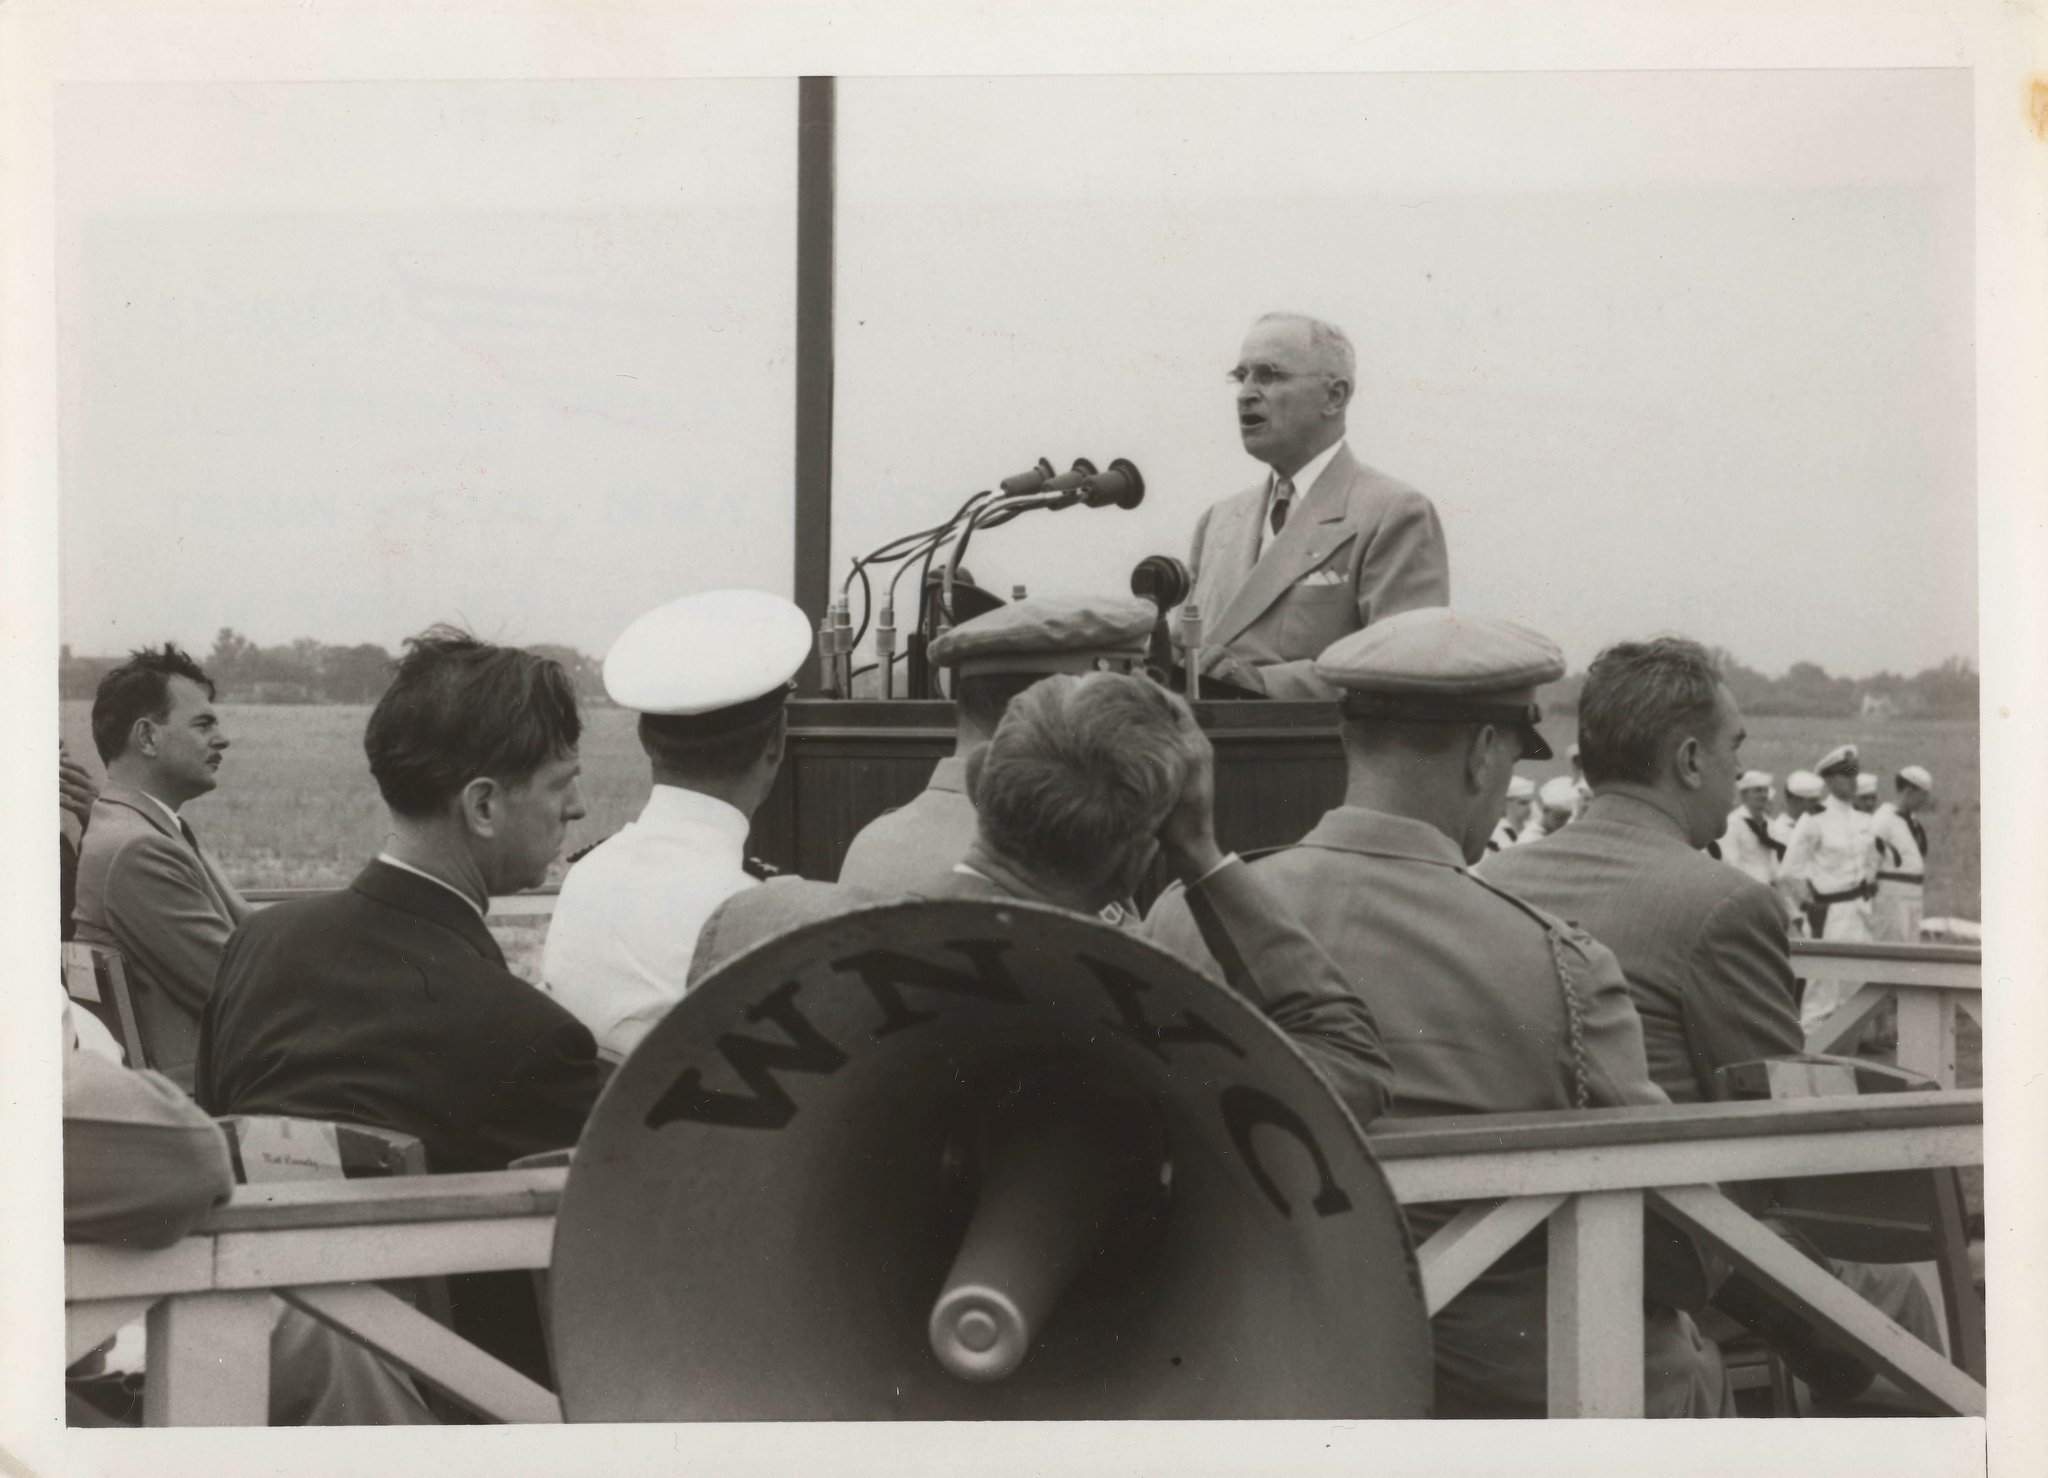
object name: news photograph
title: Truman speaks, Dewey listens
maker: Anonymous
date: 1948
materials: paper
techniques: gelatin silver print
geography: new york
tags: politics, new york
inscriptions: inscription: ‘S1093619..WATCH YOUR CREDIT..(...)’